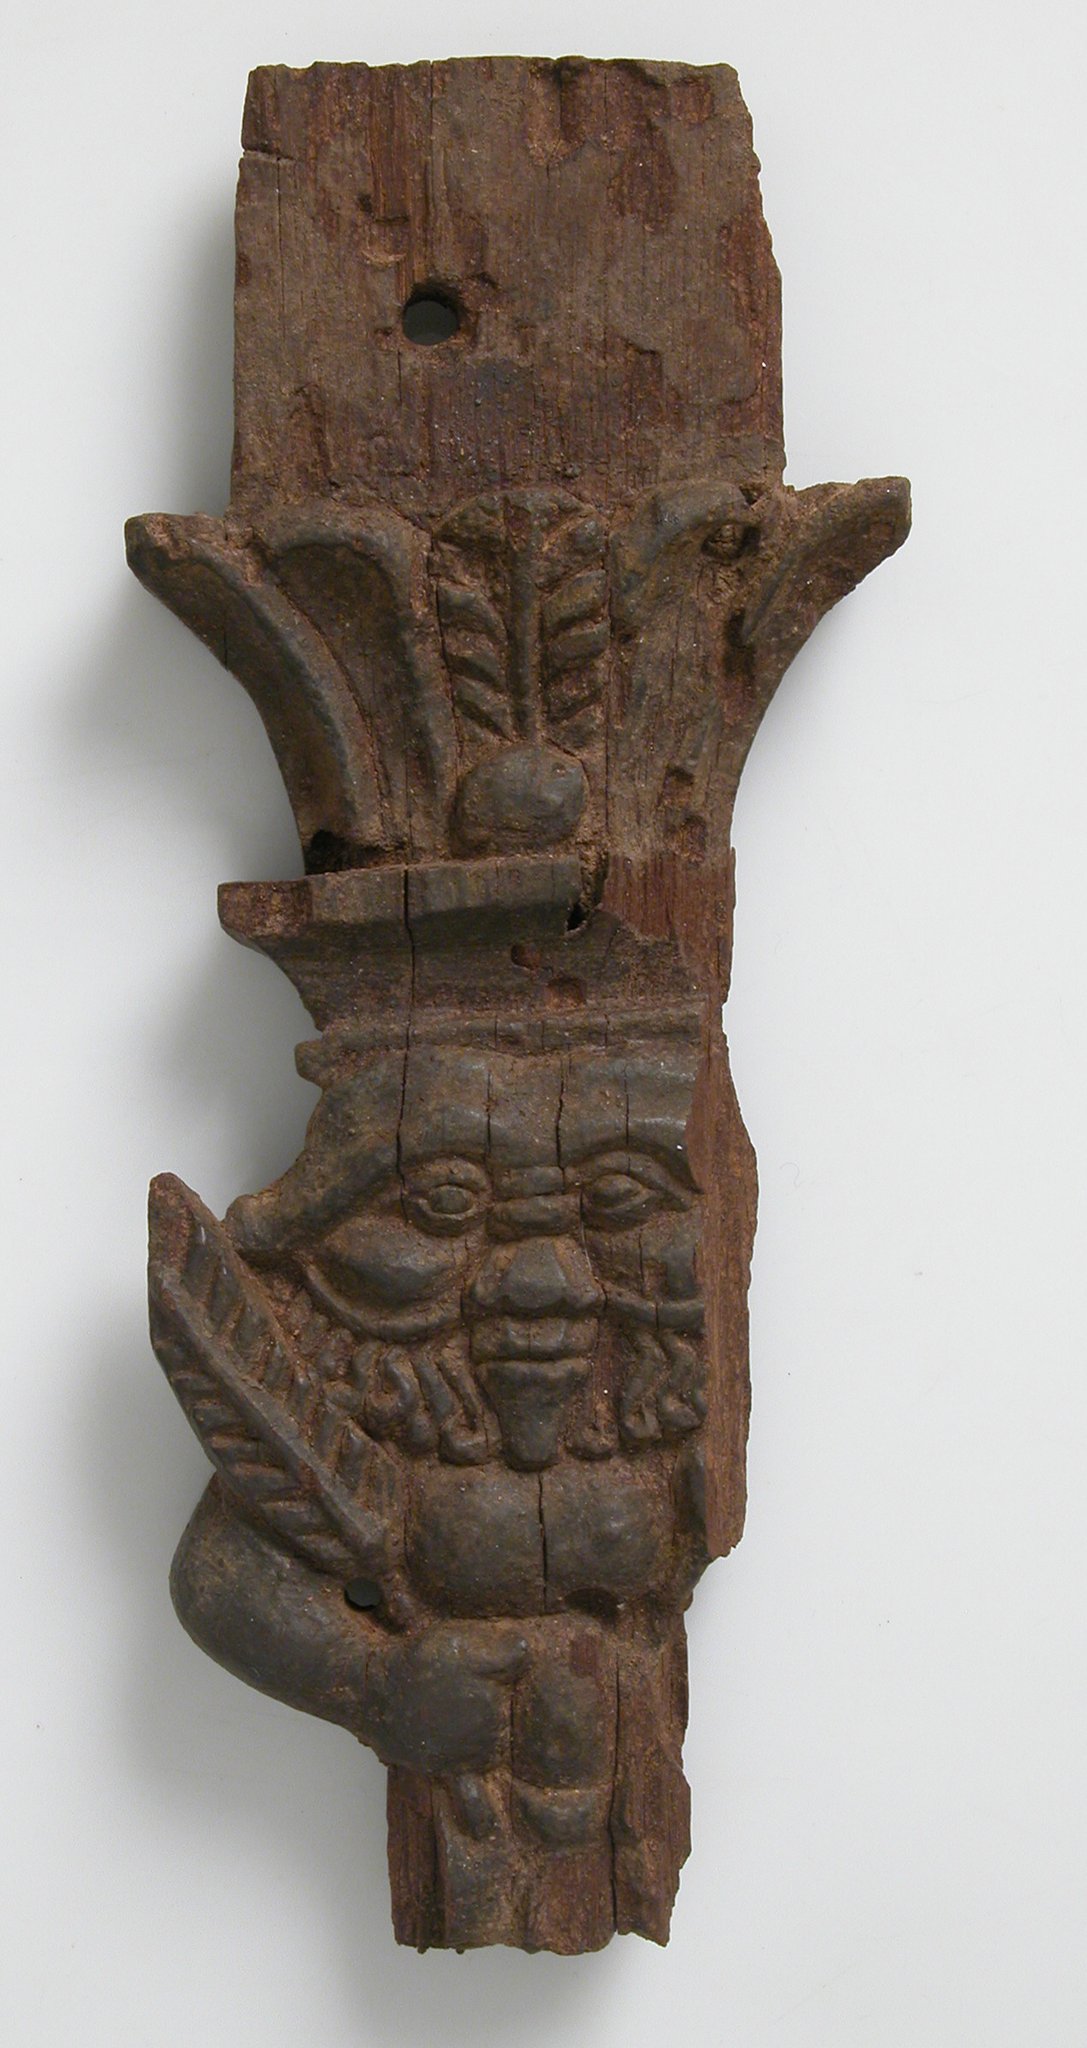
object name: be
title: Wood Bes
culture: coptic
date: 301-700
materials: wood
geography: egypt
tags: bes